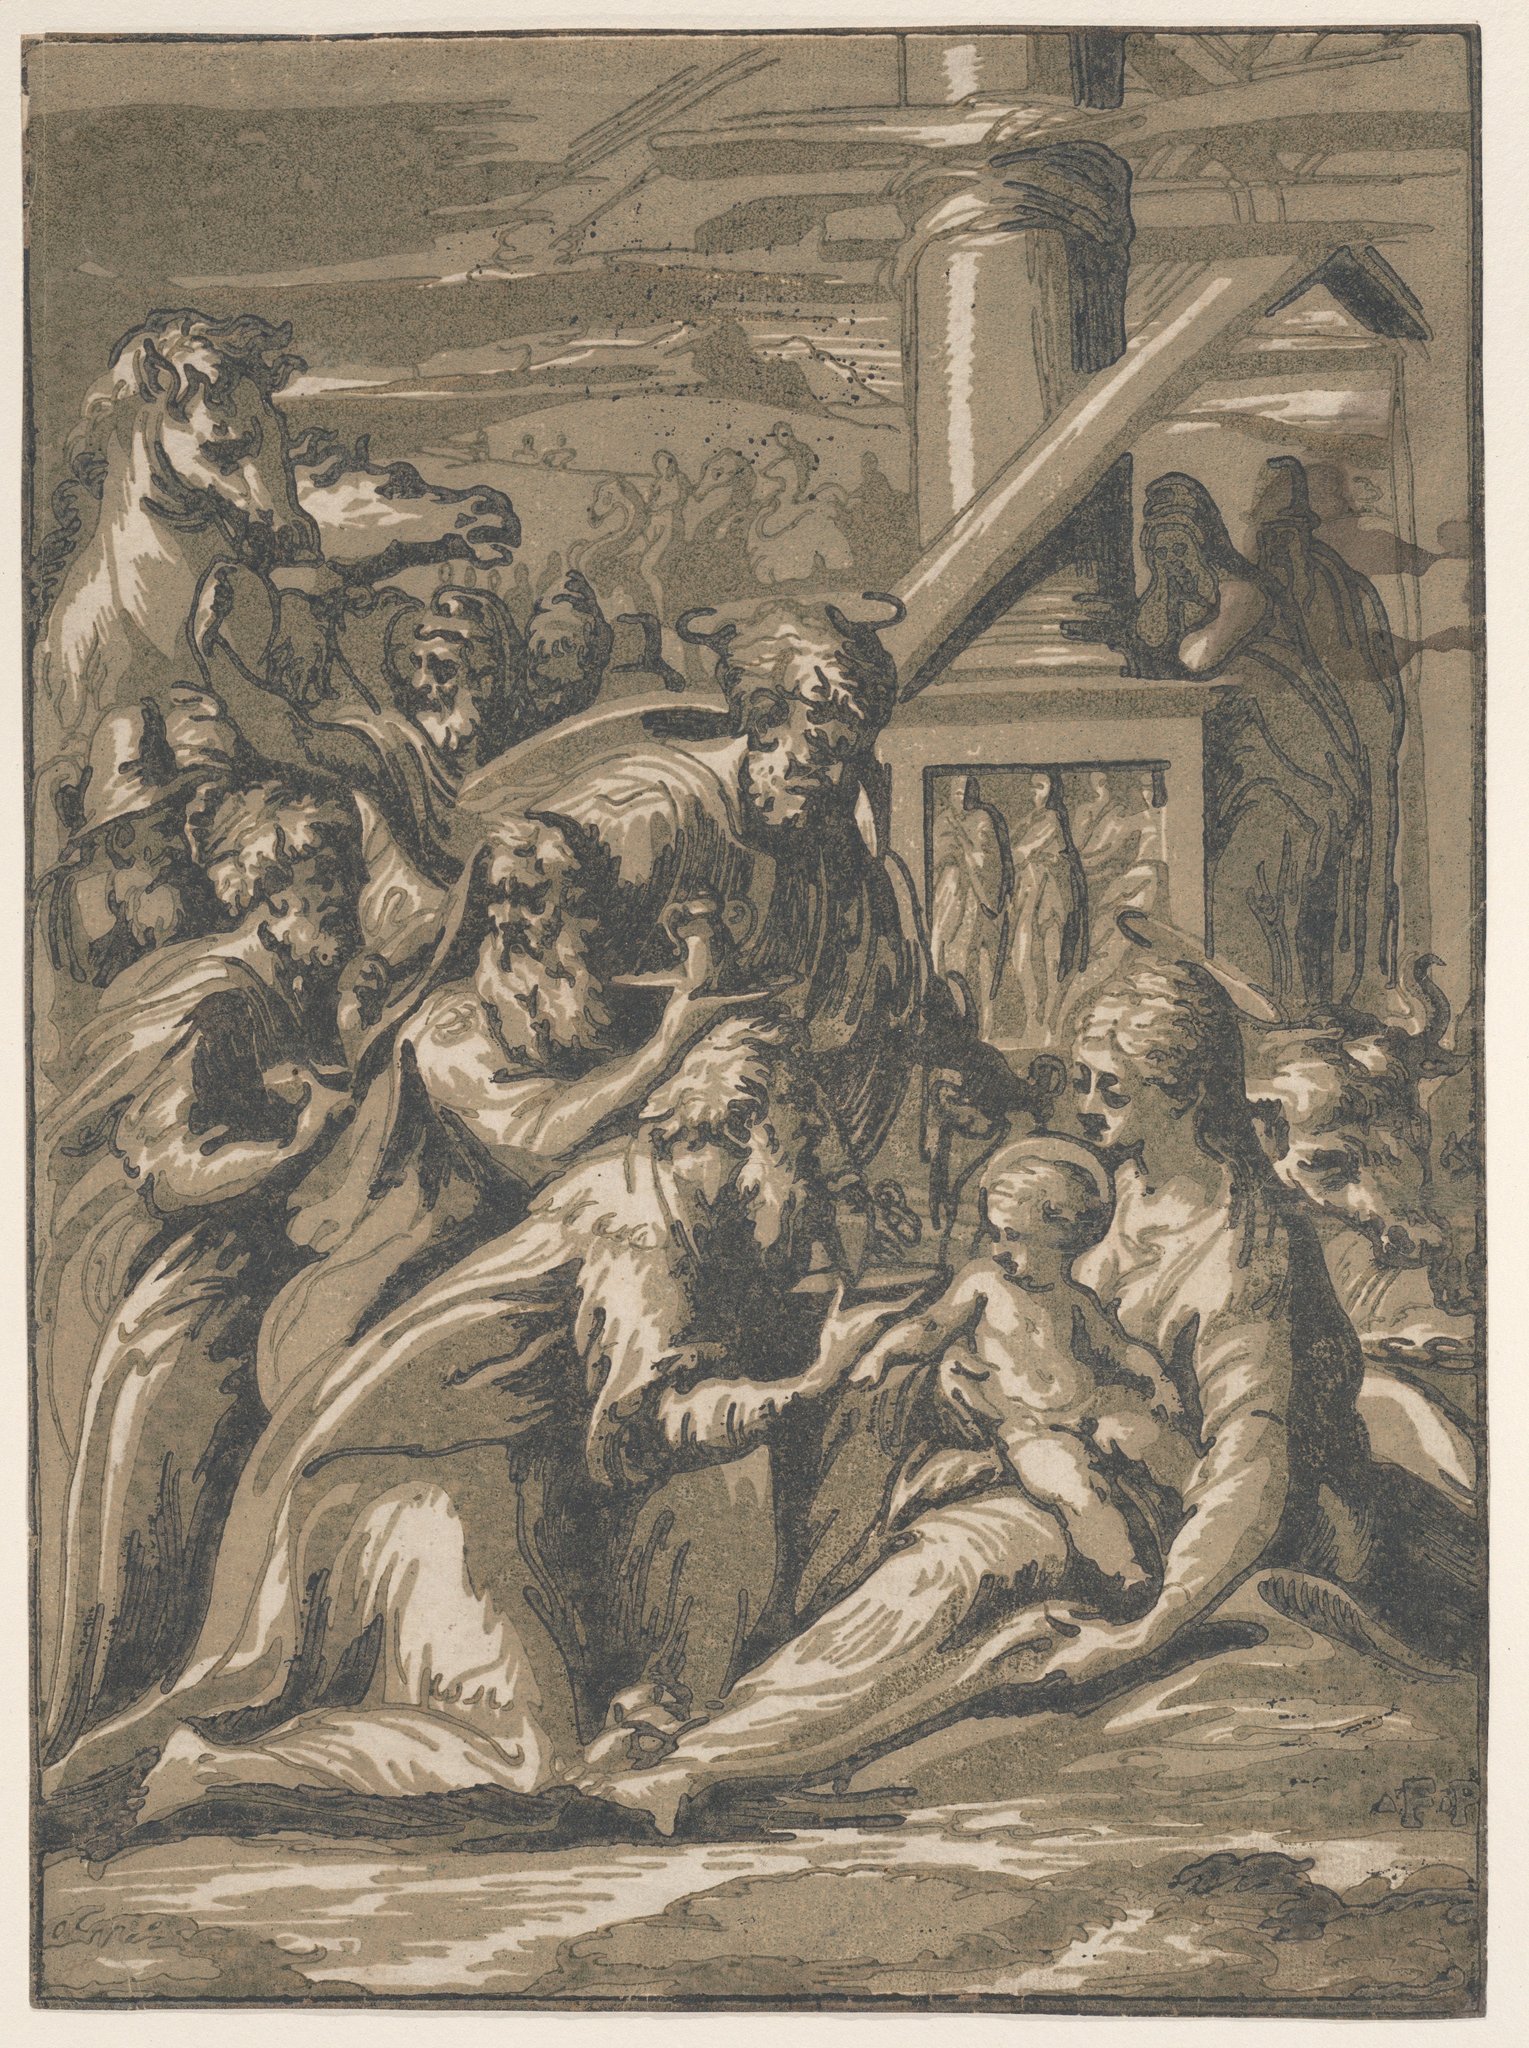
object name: print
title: Adoration of the Magi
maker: niccolò vicentino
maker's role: artist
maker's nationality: italian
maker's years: 1510-1550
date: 1540-1550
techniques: woodcut